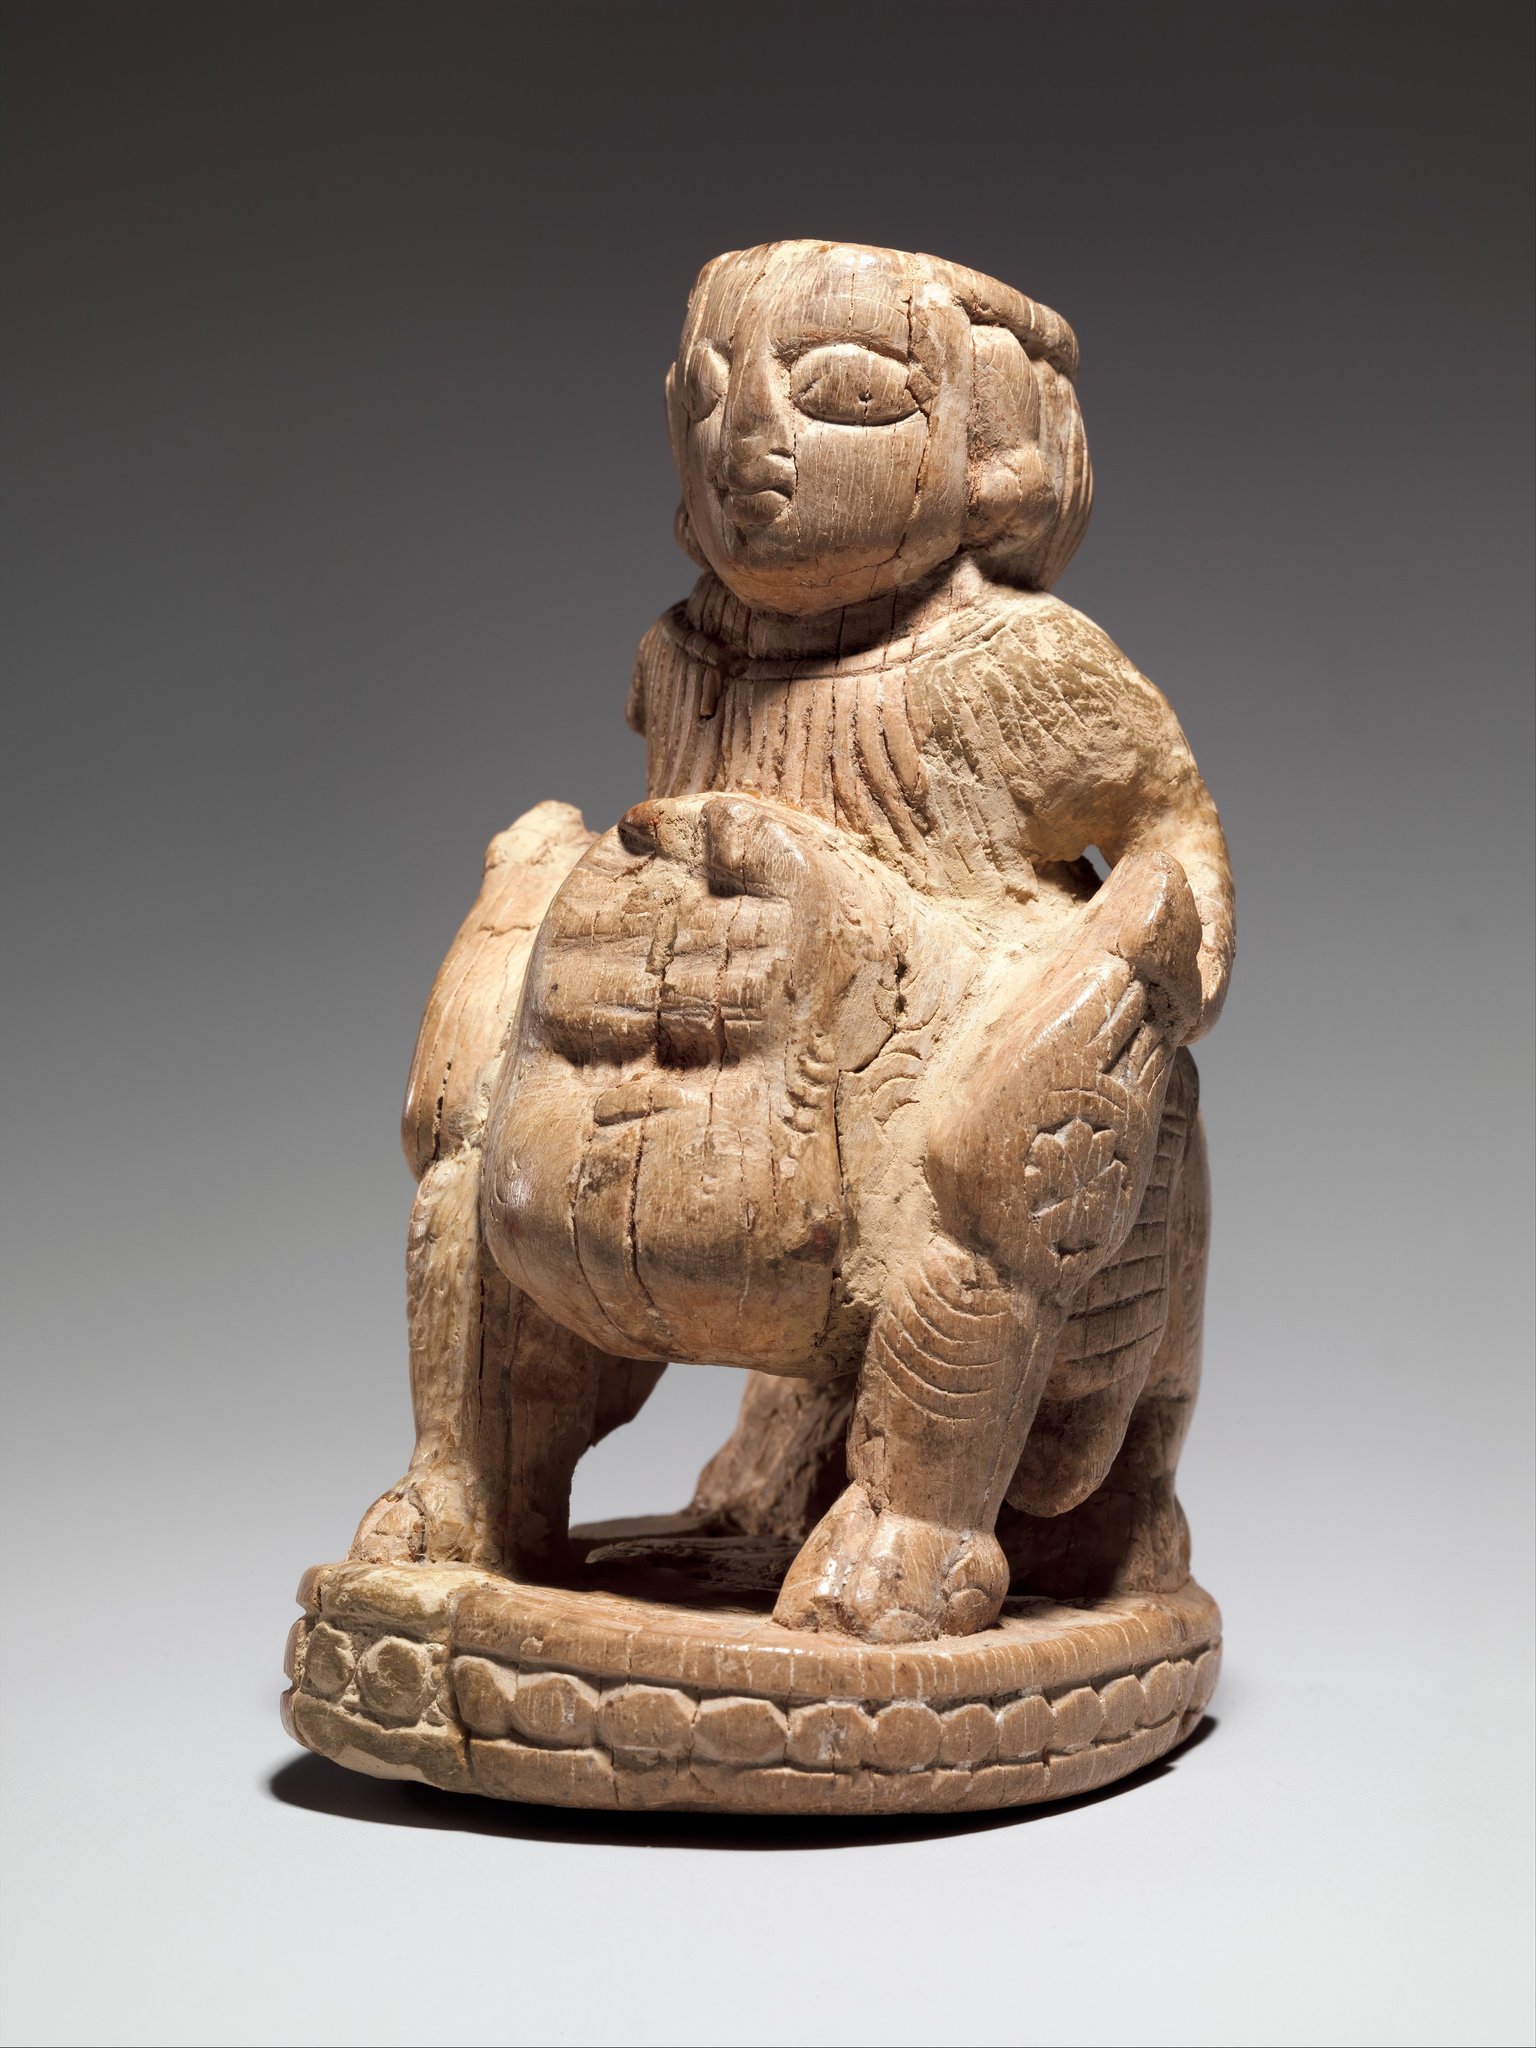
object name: chess piece or container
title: Carved Figural Chess Piece or Container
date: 1001-1200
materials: ivory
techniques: carving, incising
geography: iran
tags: chess